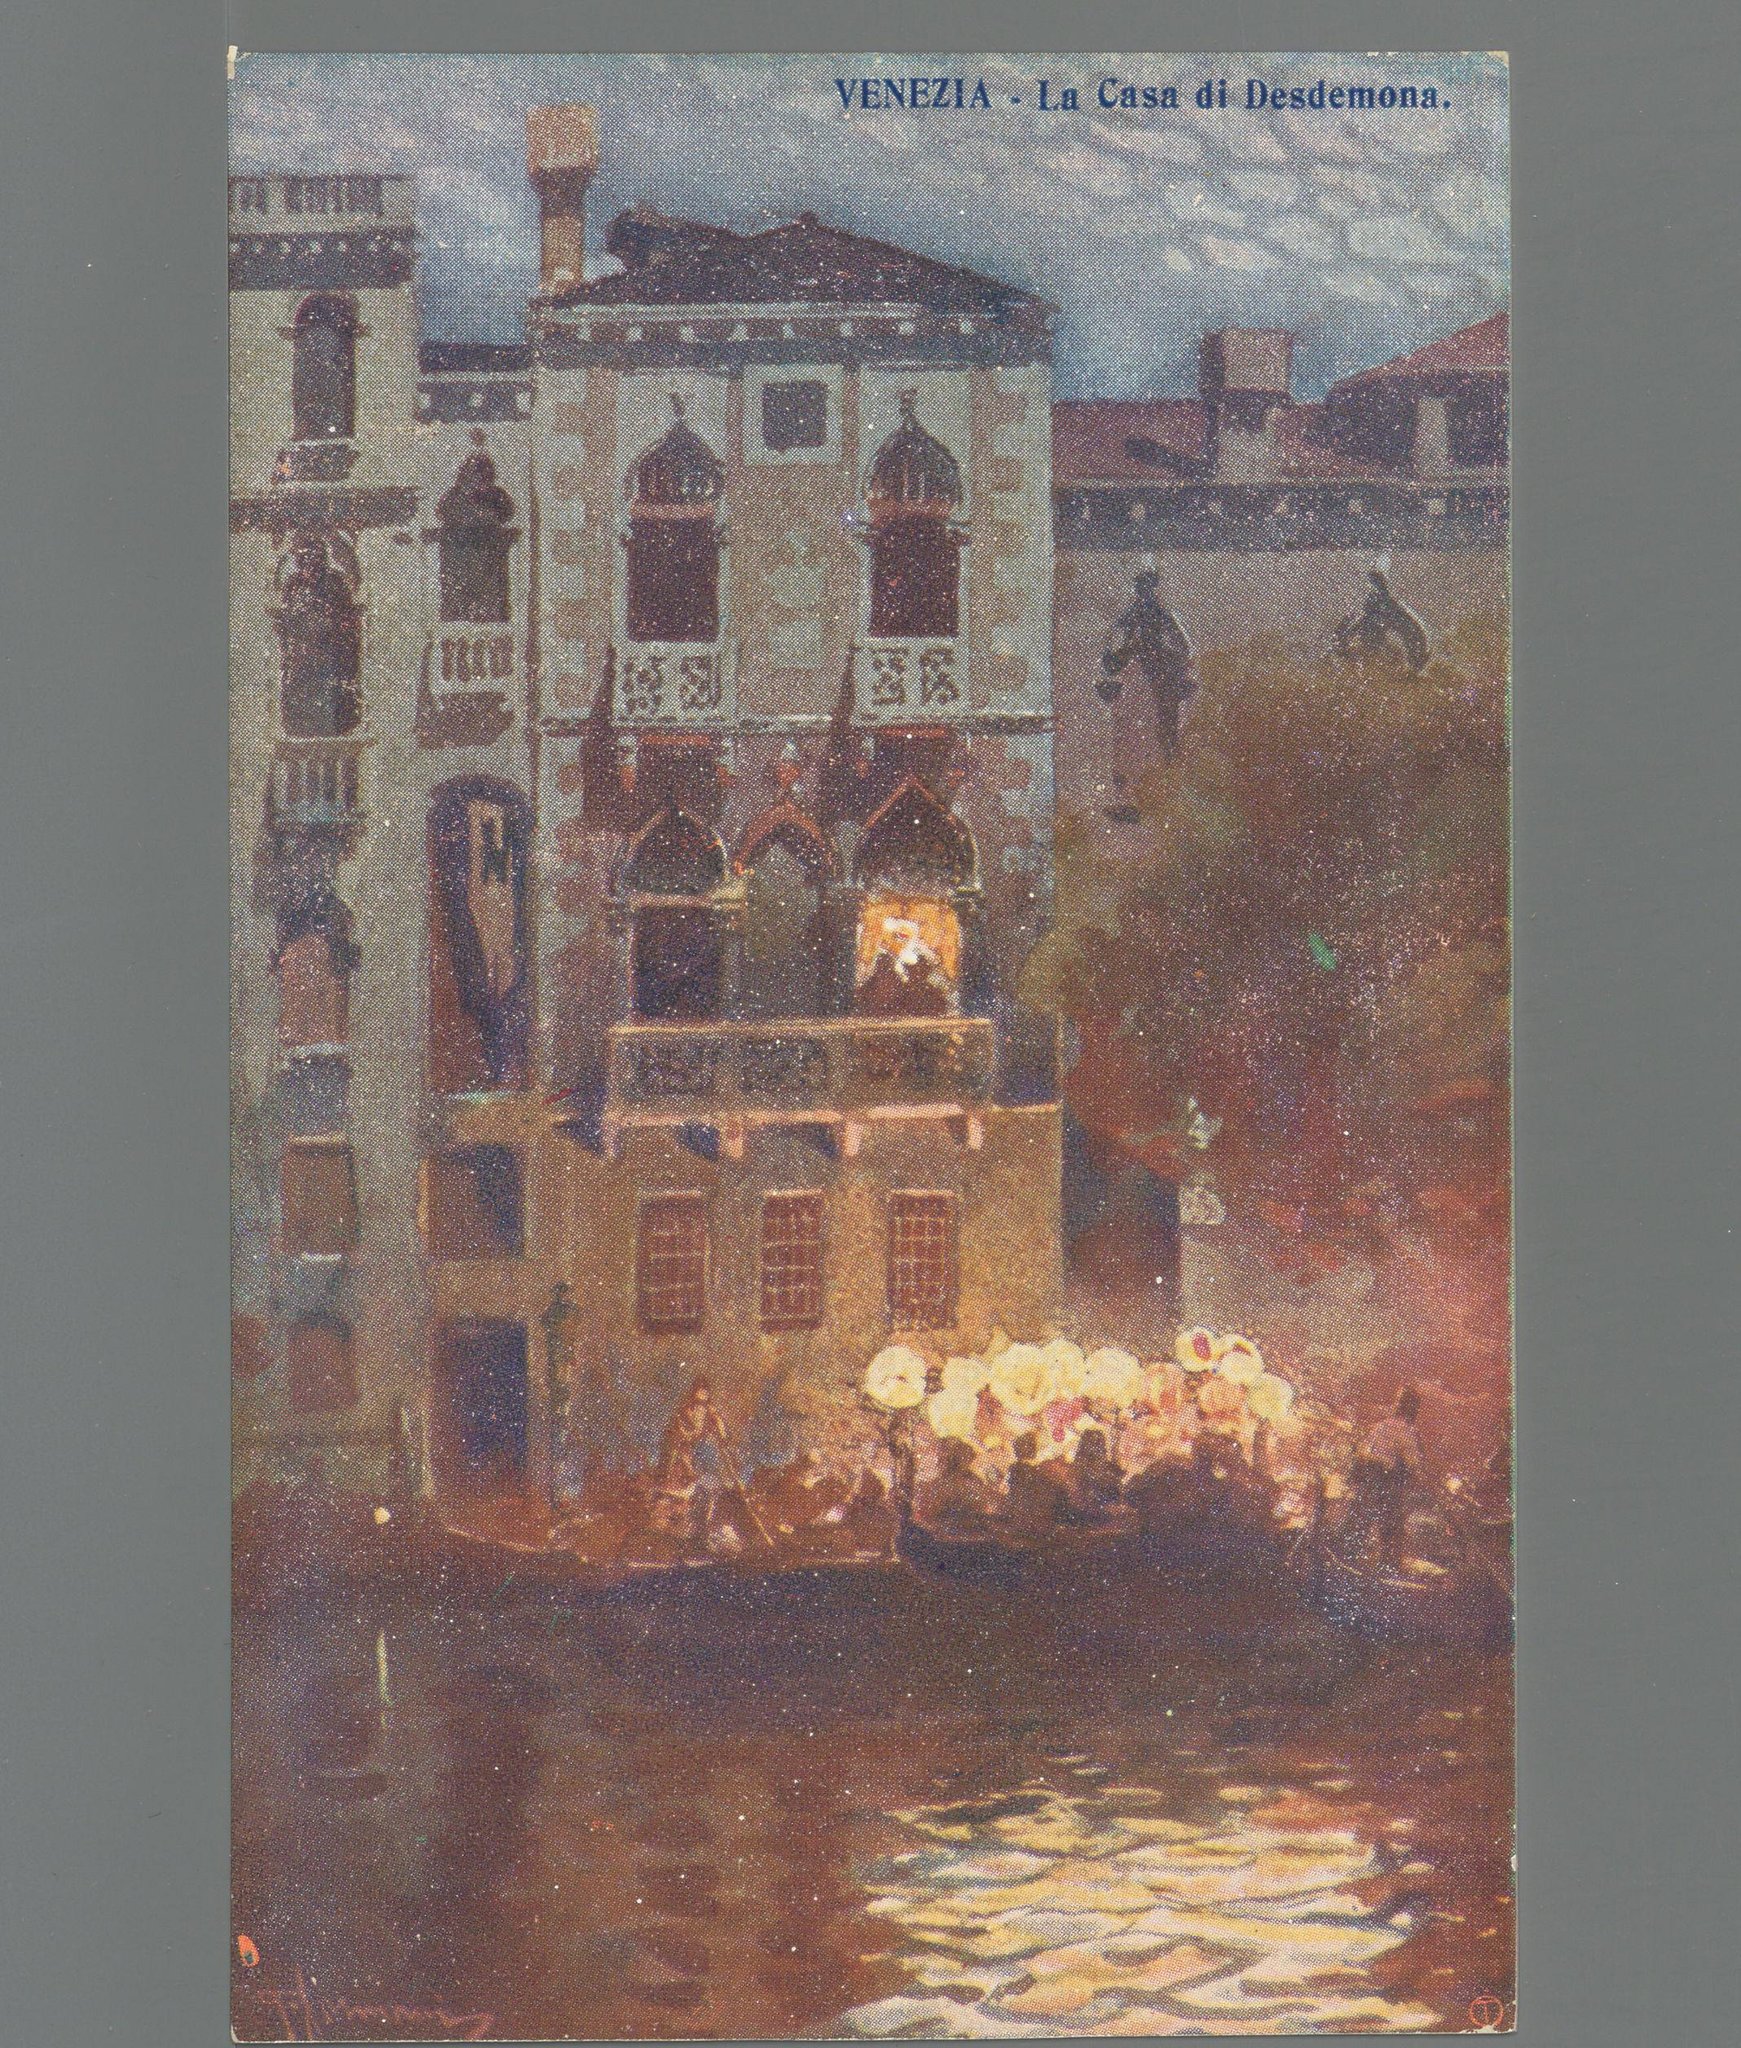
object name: reproduction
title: Venezia. La Casa di Desdemona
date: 1906-1930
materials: cardboard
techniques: three-color autotype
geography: milan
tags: hôtel, i.e. small palace in city, city-view, and landscape with man-made constructions (+ city(-scape) with figures, staffage), night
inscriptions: signature